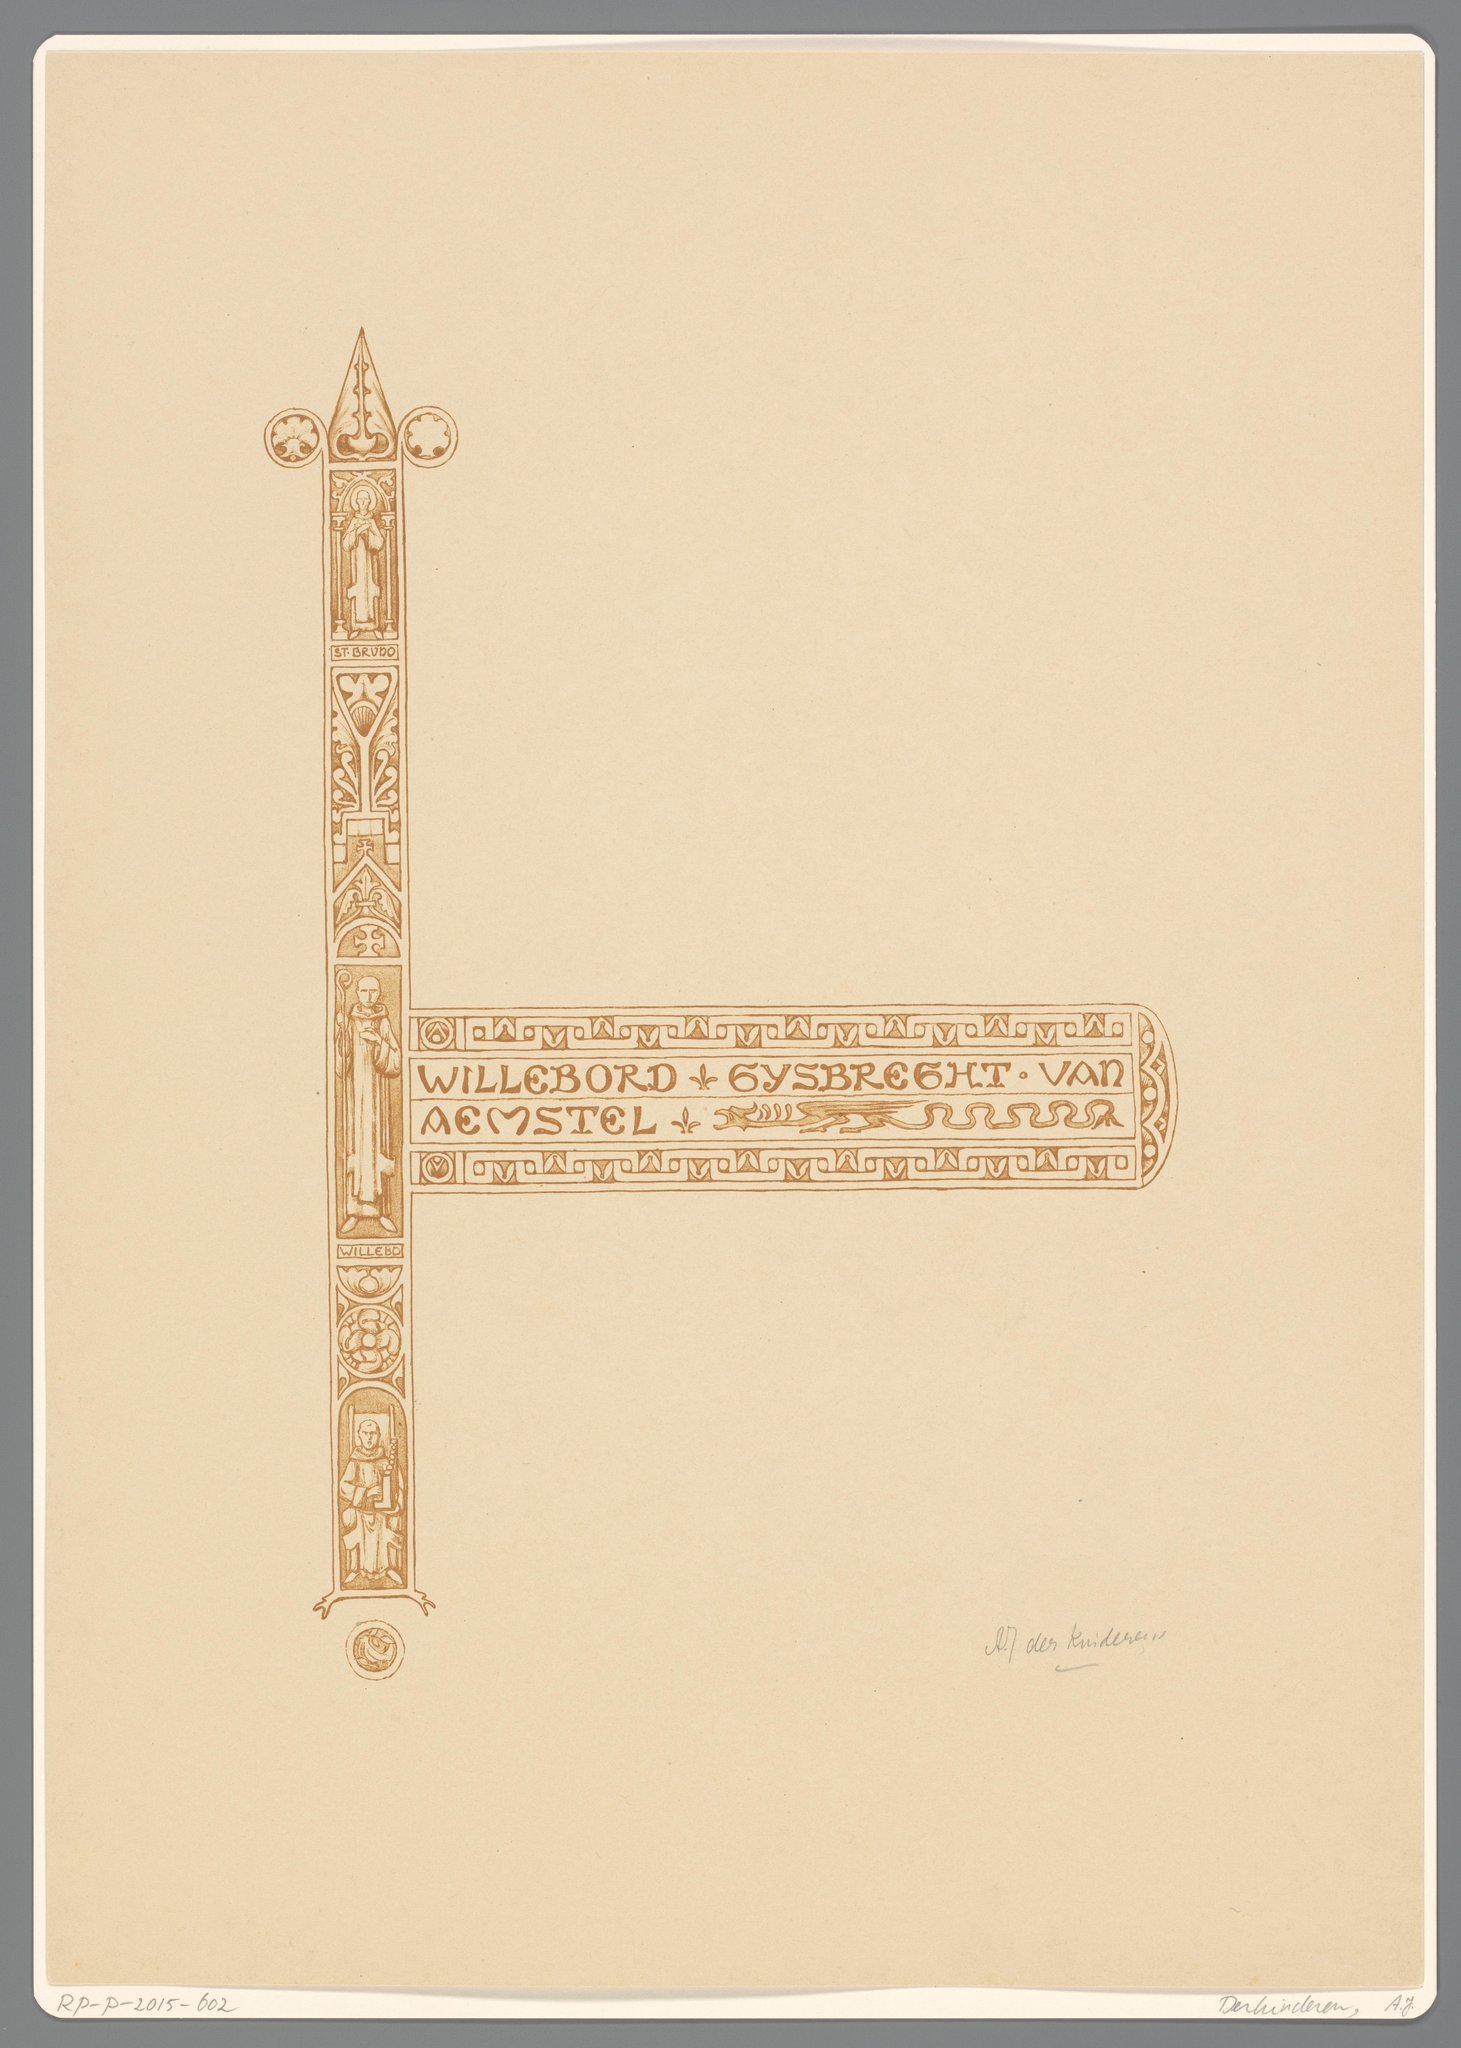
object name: print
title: Willebord, Gysbreght van Aemstel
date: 1894-1901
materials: paper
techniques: lithograph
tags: saints, monk(s), friar(s)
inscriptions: collector's mark: Lugt 2233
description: Een horizontale, decoratieve titelband waarin de prior Willebrord en Gijsbrecht van Aemstel worden aangekondigd. Links van de titelband een verticale sierrand met daarin de beeltenissen van Sint Bruno met gevouwen handen en Willebrord met staf.